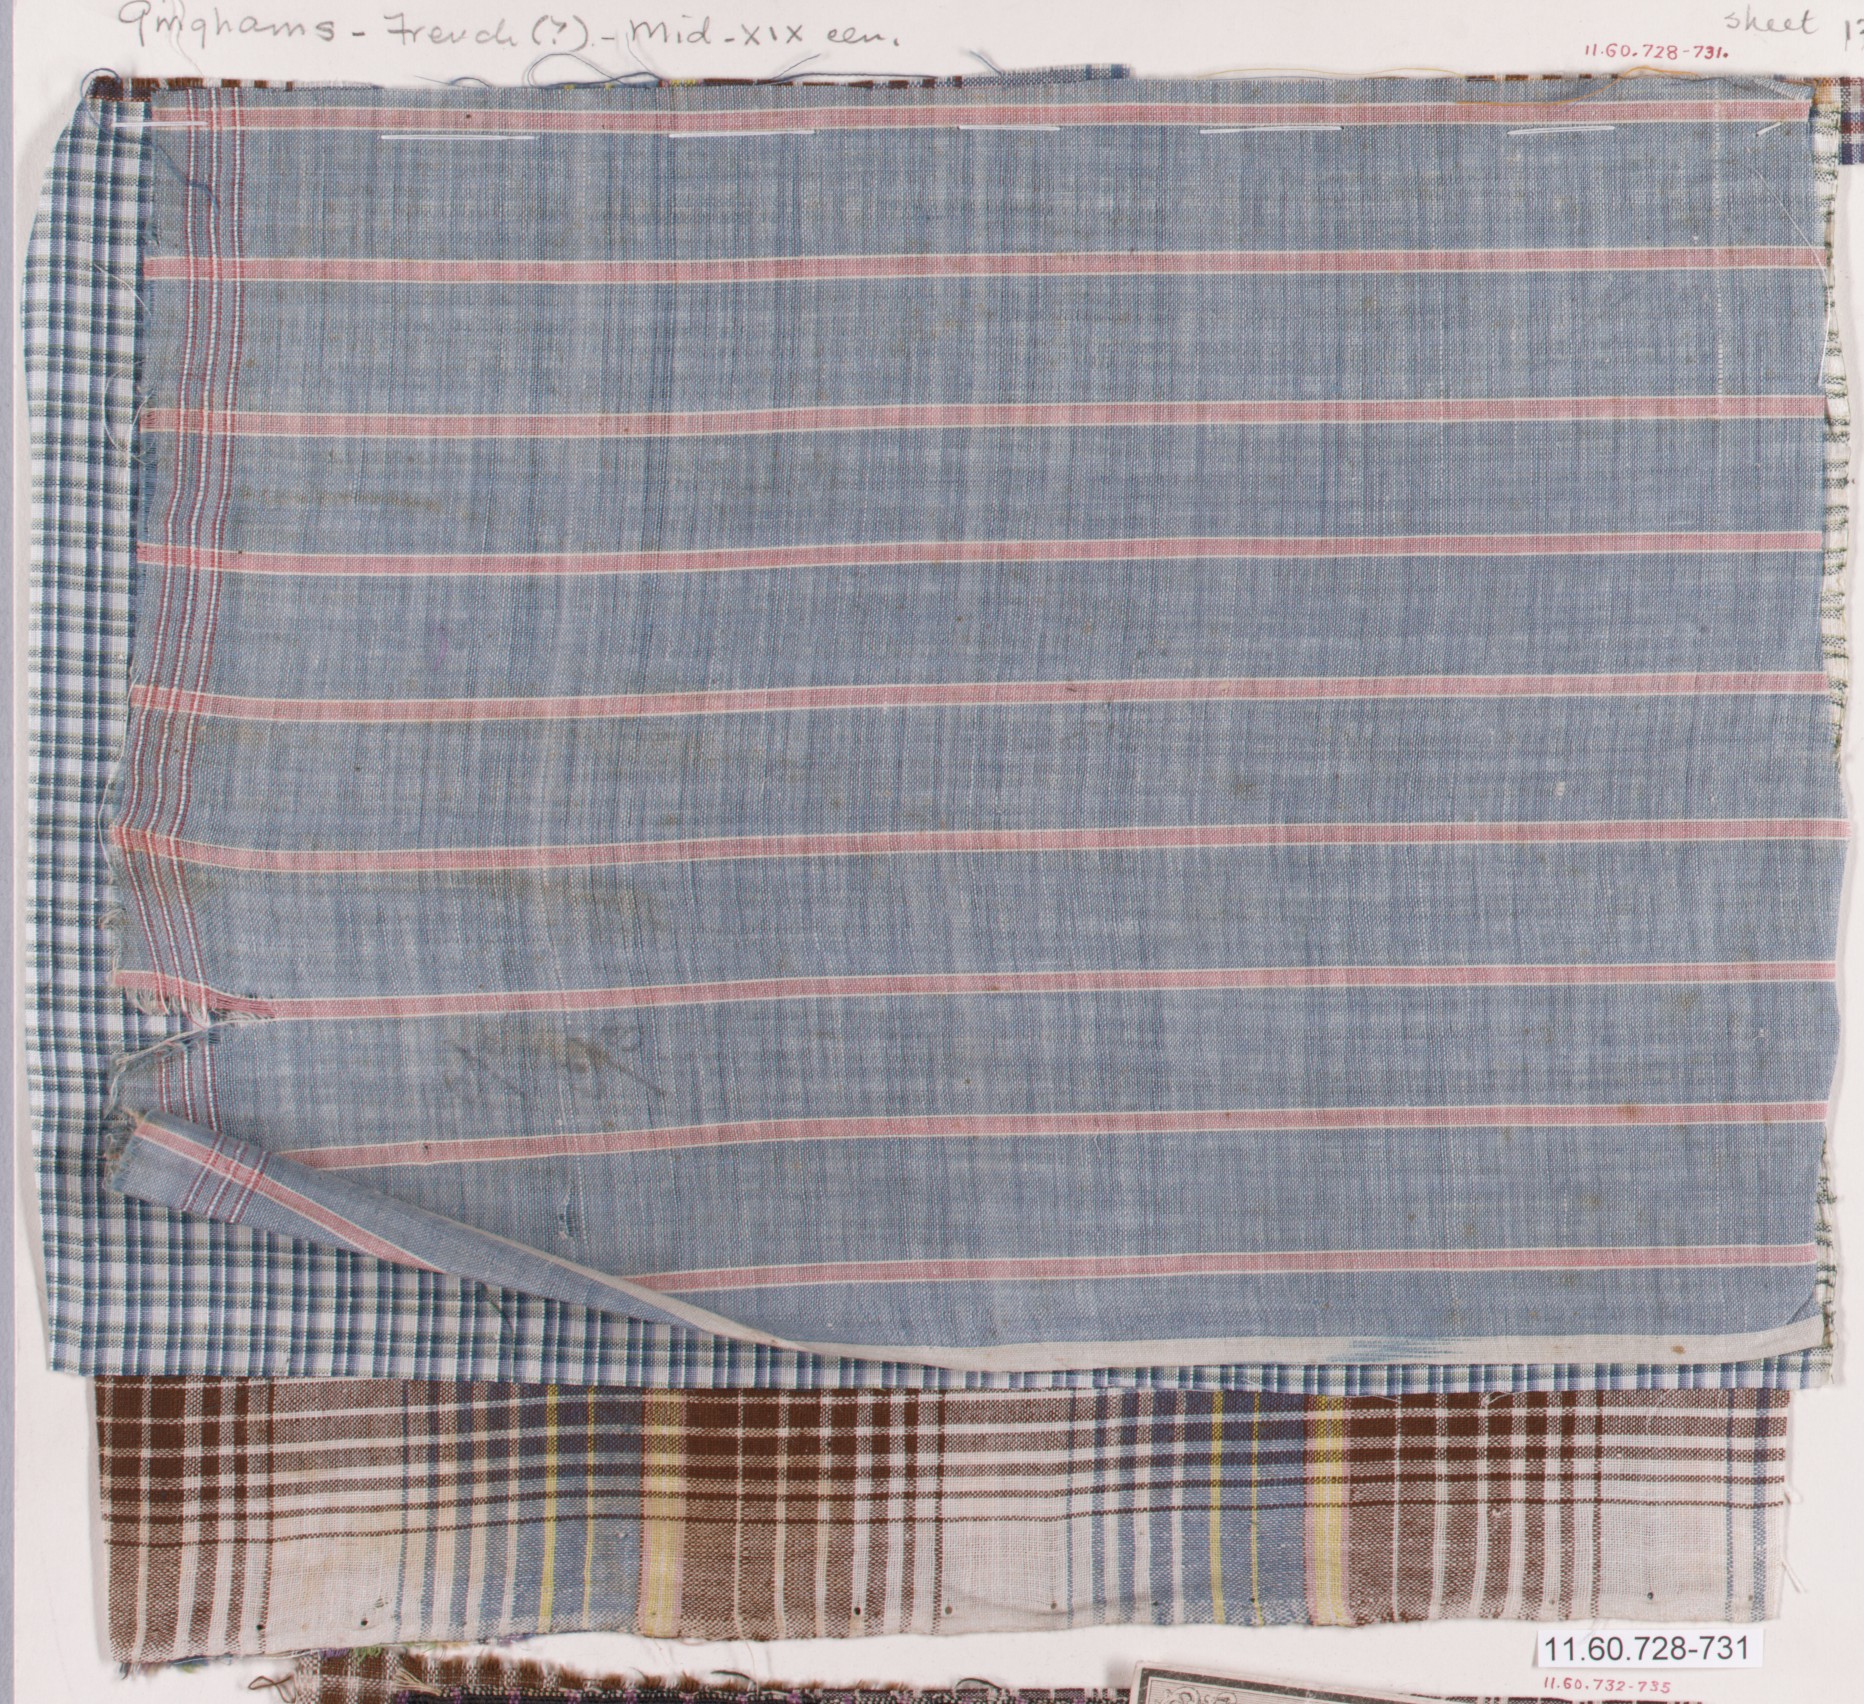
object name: sample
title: Samples (4)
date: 1834-1866